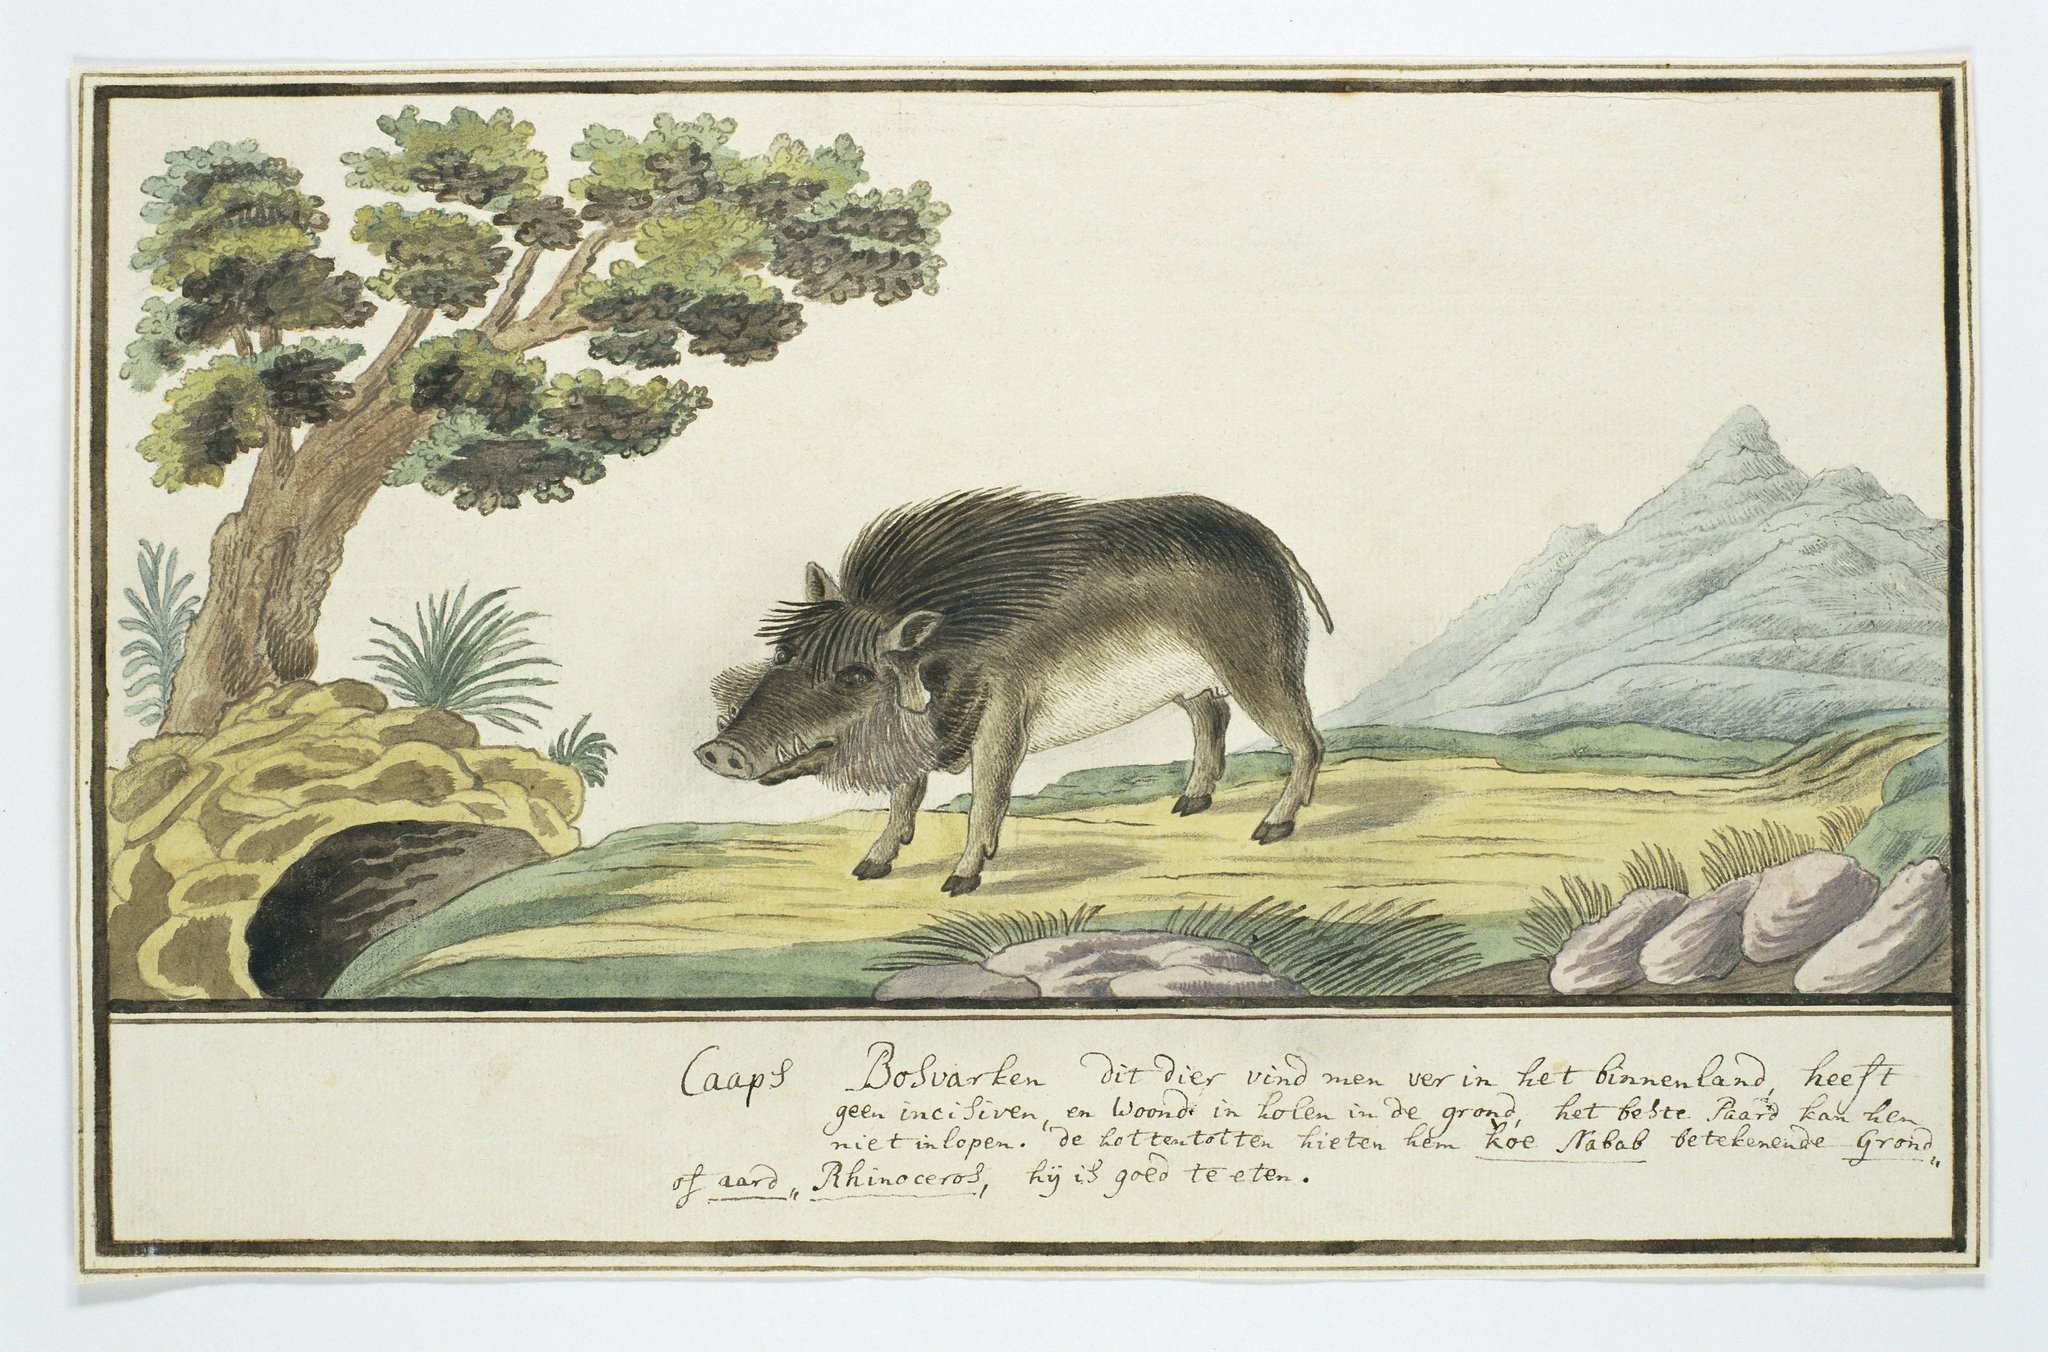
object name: album leaf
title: Phacochoerus aethiopicus aethiopicus (Cape warthog)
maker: robert jacob gordon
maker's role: draughtsman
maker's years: 1743-1795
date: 1712-1778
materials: chalk, paint, ink, paper, pencil, watercolor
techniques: brush, pen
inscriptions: annotation: ‘Caaps Bosvarken. [...]’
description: Volgens L.C. Rookmaker heeft Gordon geen aandacht aan dit soort zwijn besteed, maar de tekening laat wel de kenmerkende slagtanden van de soort zien. In de tentoonstelling van 2002 wrattenzwijn genoemd.